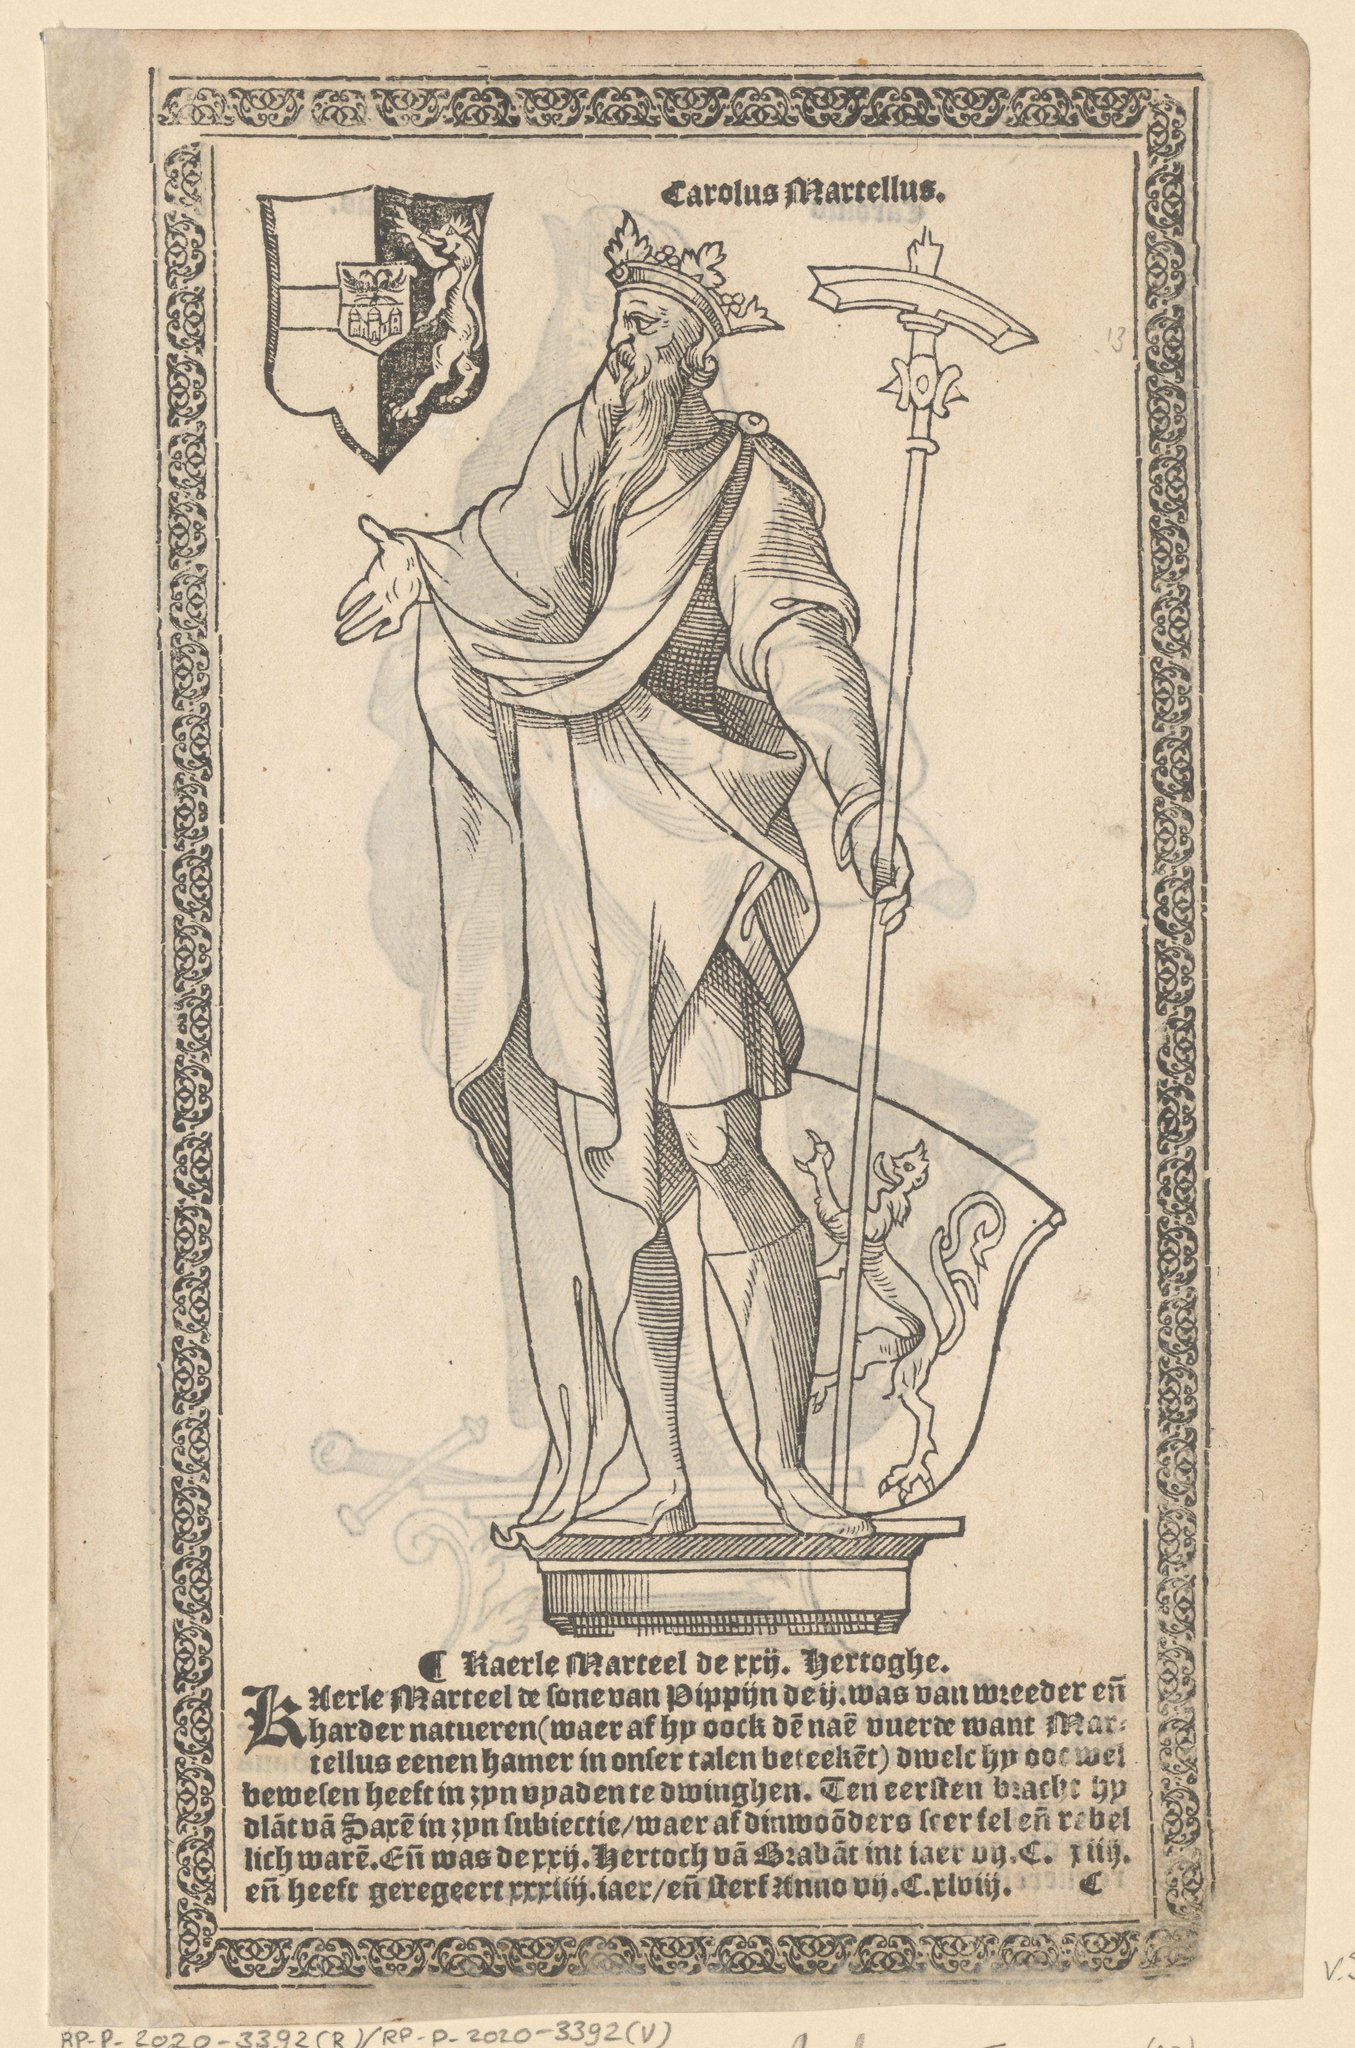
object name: print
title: Portret van Karel Martel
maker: jan molijns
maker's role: print maker, publisher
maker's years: 1498-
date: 1565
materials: paper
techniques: letterpress printing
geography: antwerp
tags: historical persons, armorial bearing, heraldry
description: Prent uit: Dit is die afcoemste ende genalogie der hertoghen ende hertoginnen van Brabandt, (...). Antwerpen: Jan Molijns, 1565.